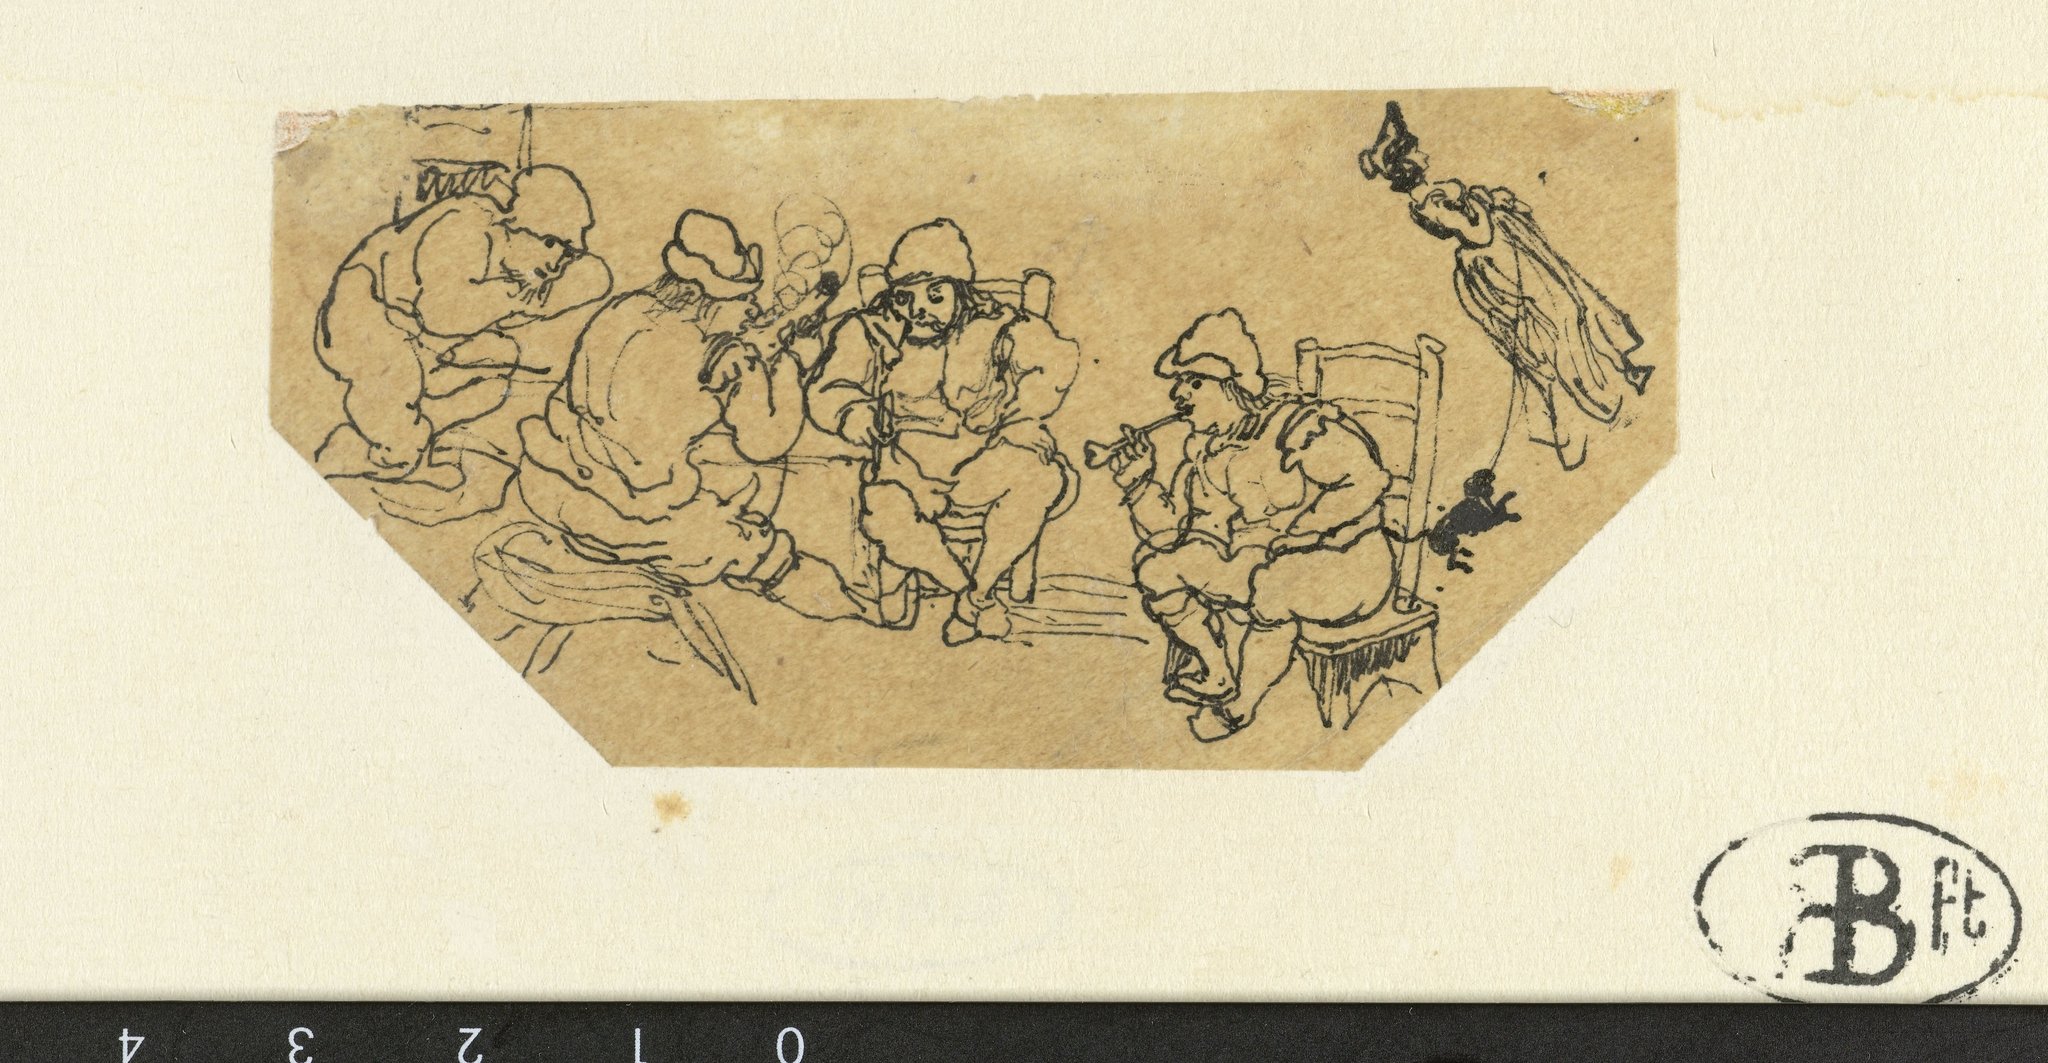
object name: drawing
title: Rokende boeren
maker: rodolphe bresdin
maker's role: draughtsman, print maker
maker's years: 1822-1885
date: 1832-1885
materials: ink, paper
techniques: pen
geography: france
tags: pipe ~ tobacco